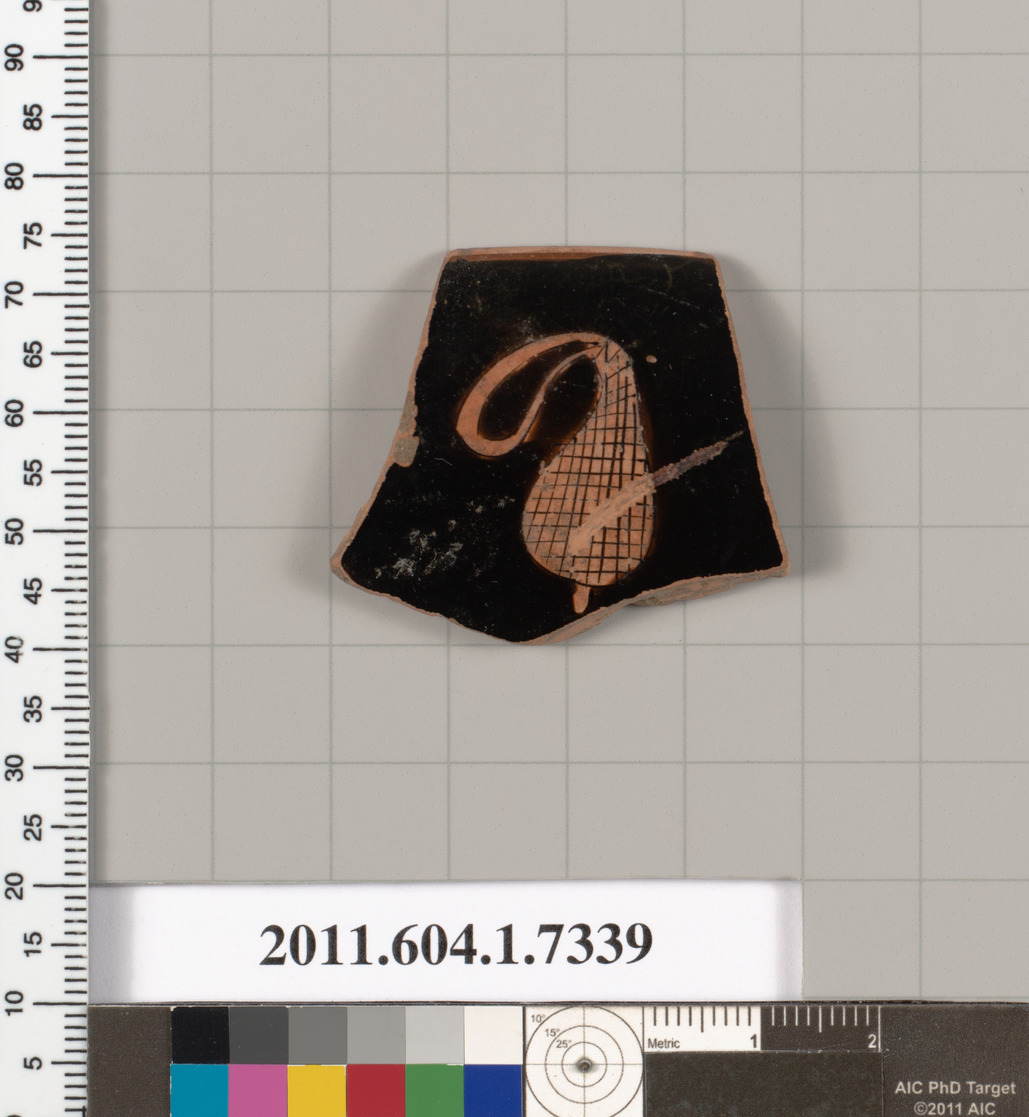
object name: kylix fragment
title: Terracotta rim fragment of a kylix (drinking cup)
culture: greek, attic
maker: makron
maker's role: artist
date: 500-480 BCE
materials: terracotta